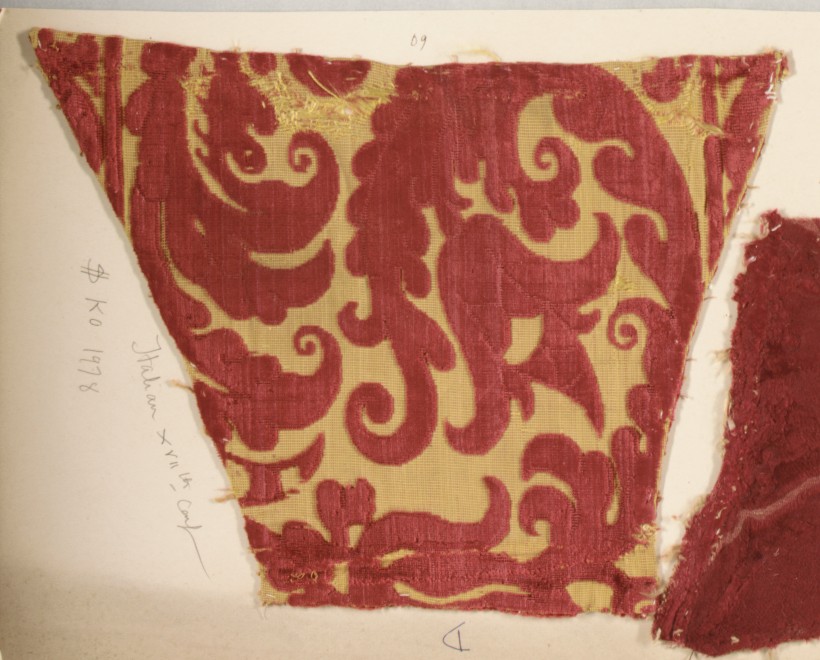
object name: fragment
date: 1601-1700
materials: silk